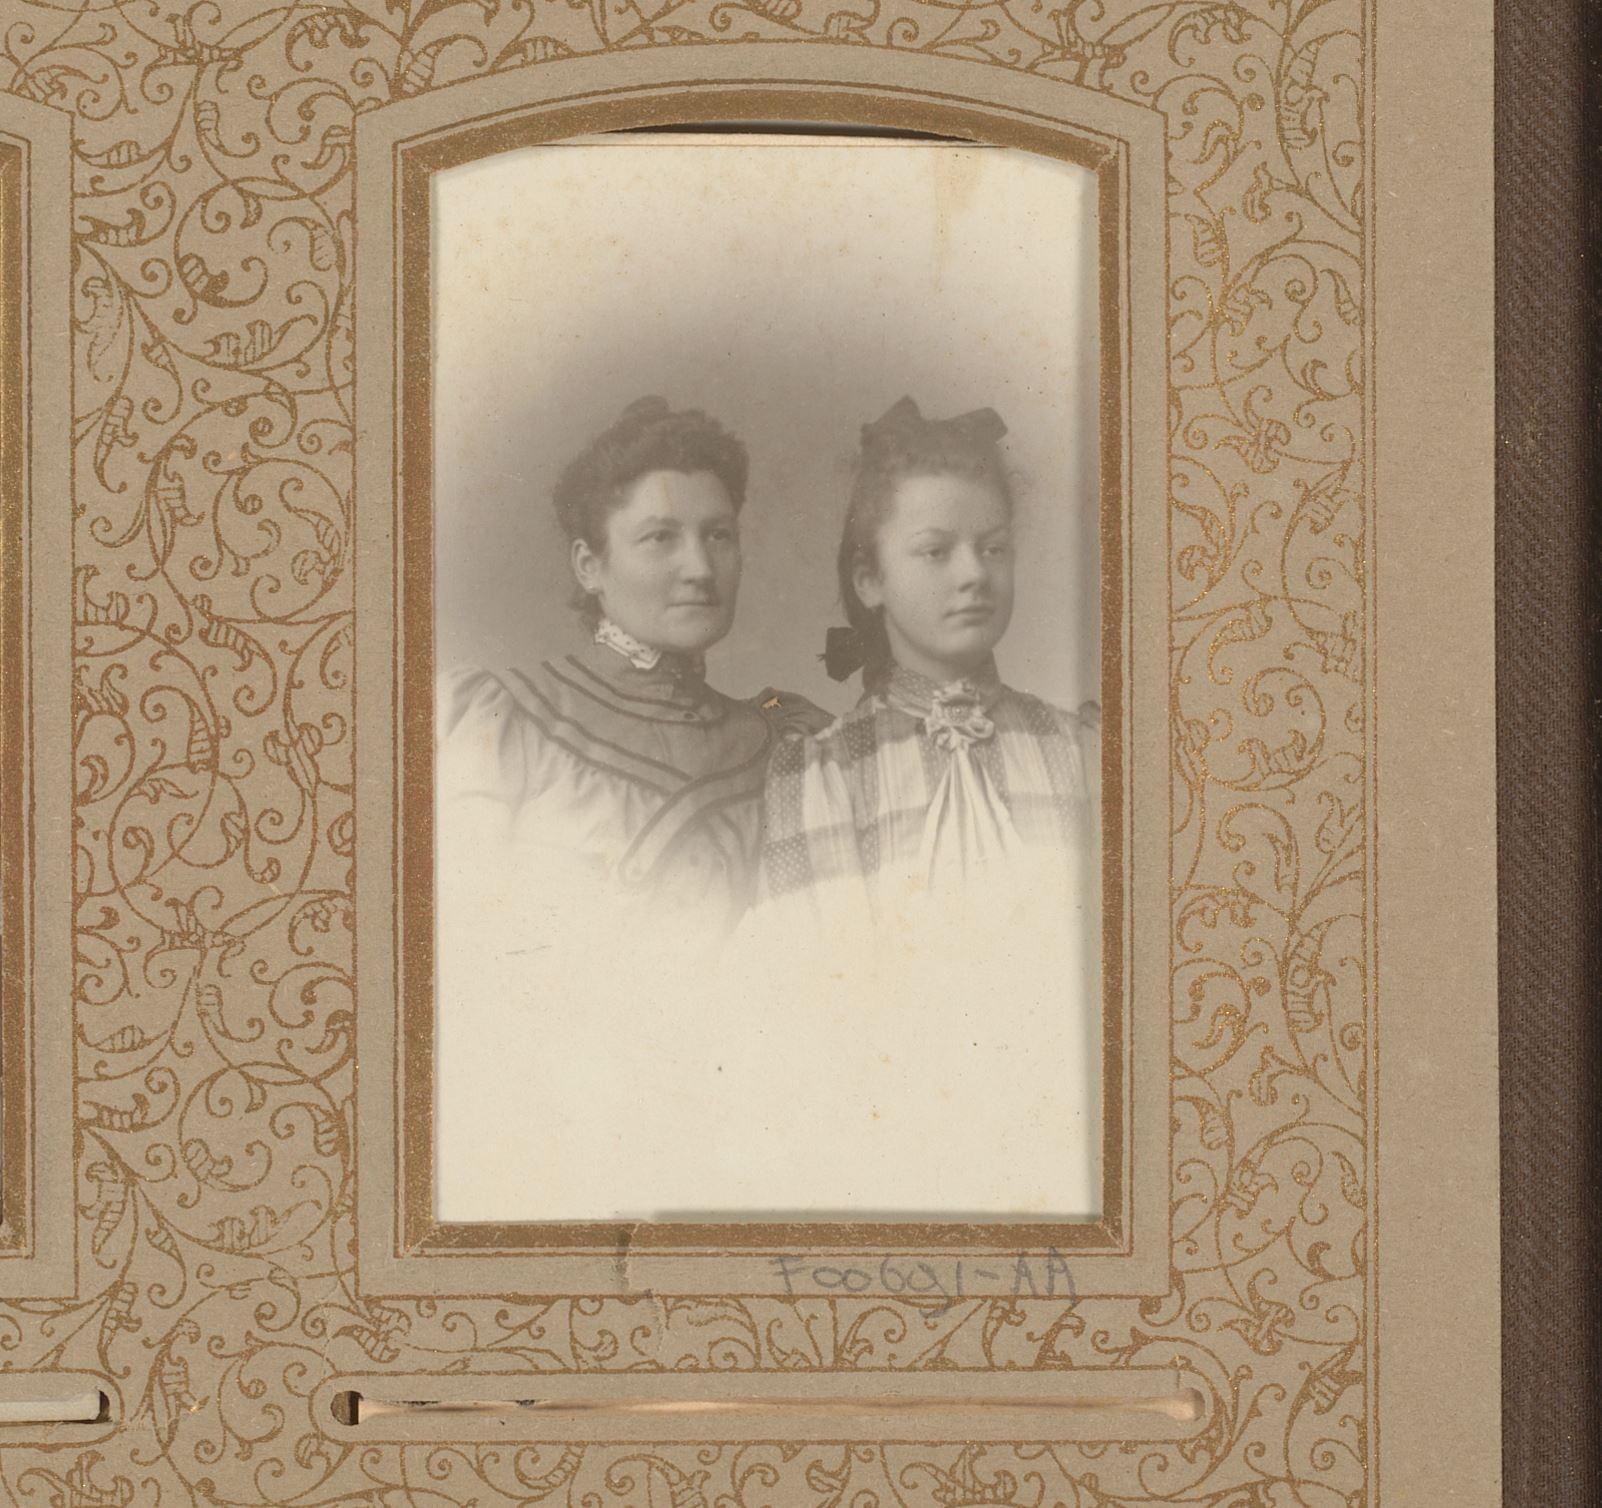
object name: carte de visite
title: Portret van een jonge vrouw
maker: j.w. wentzel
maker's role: fotograaf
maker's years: 1855-1930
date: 1890-1898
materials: cardboard, photographic support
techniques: collodion silver print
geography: amersfoort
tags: adolescent, young woman, maiden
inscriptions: inscription: ‘J.W. Wentzel/ Amersfoort/ Langestraat F.12’